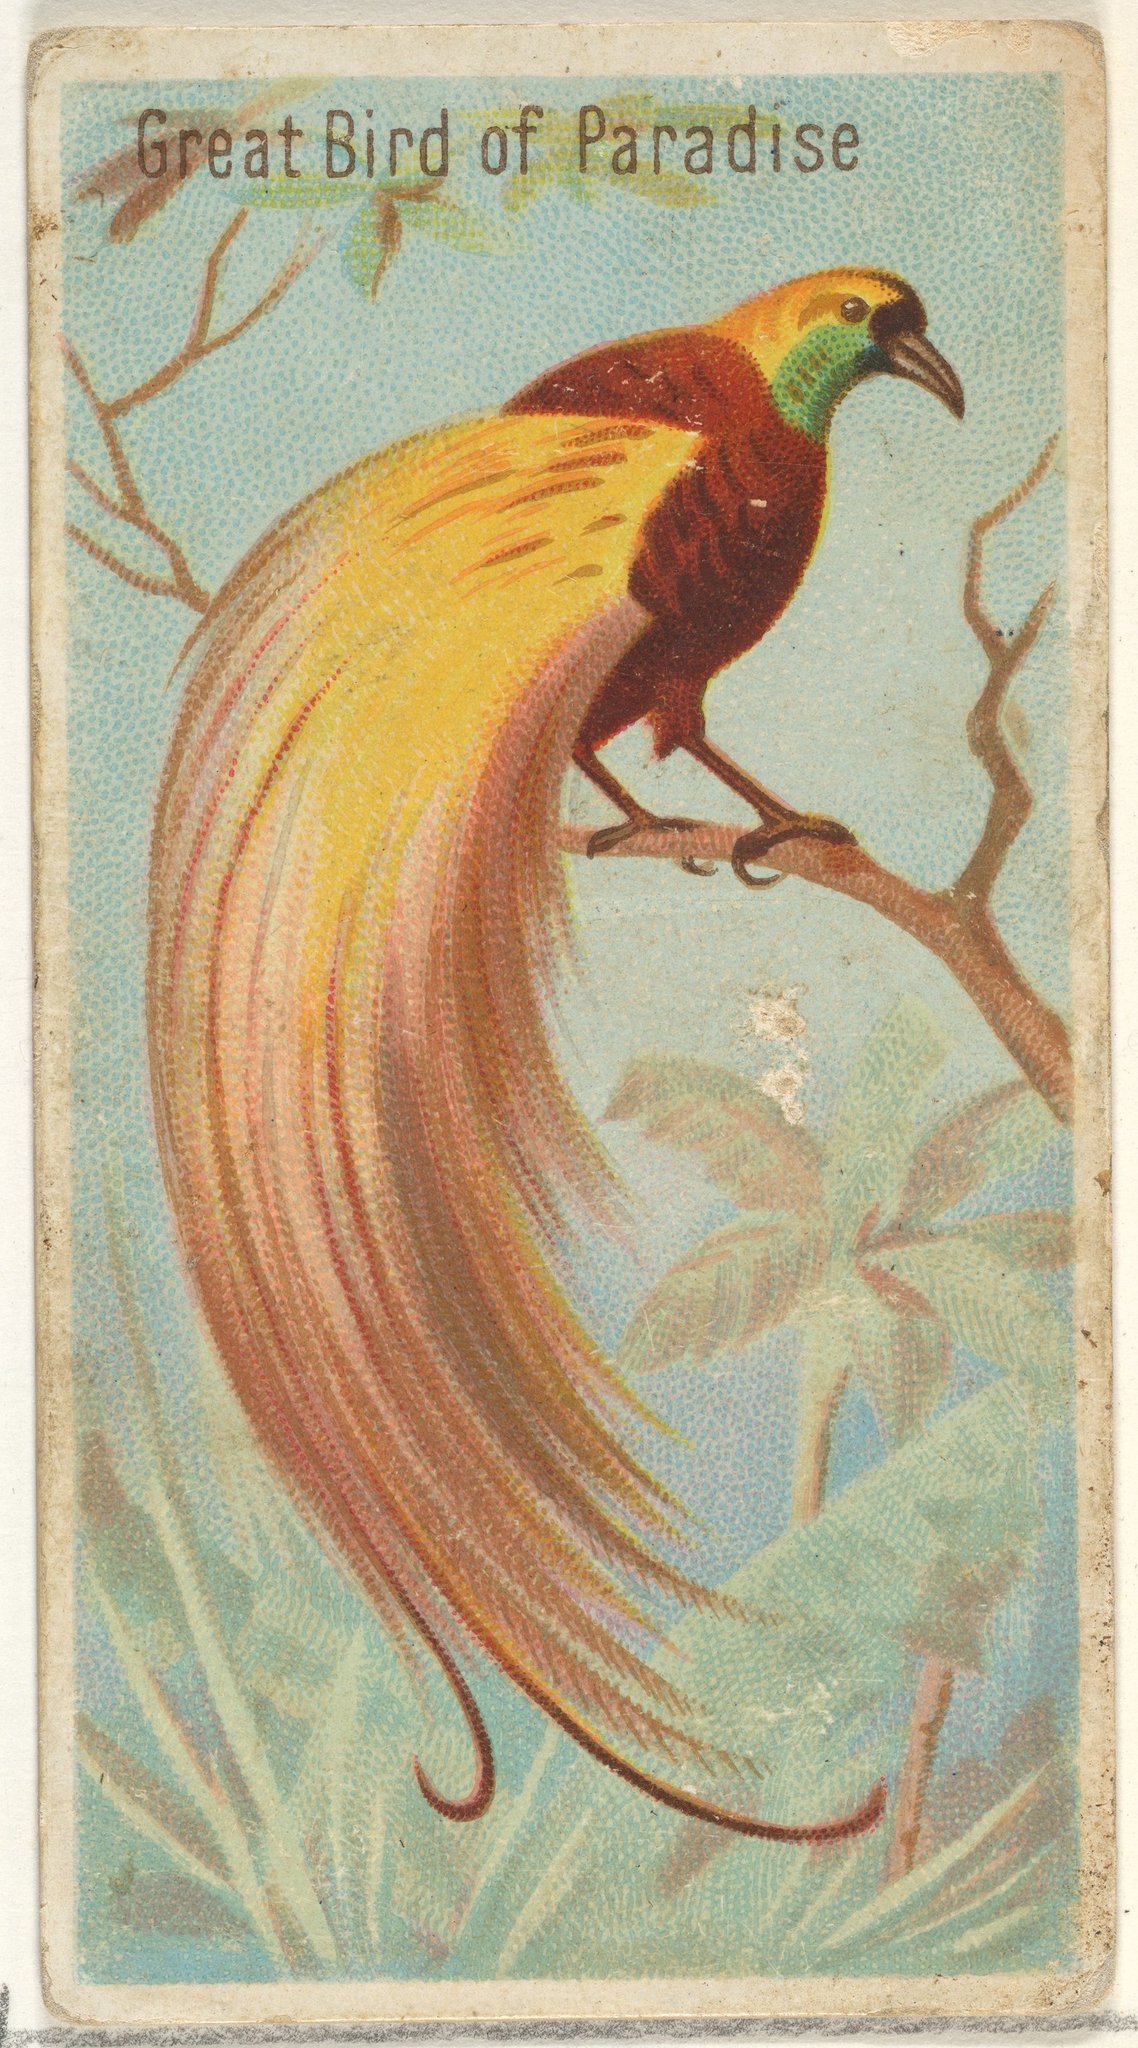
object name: print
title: Great Bird of Paradise, from the Birds of the Tropics series (N5) for Allen & Ginter Cigarettes Brands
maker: allen & ginter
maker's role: publisher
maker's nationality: american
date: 1889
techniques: color lithograph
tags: birds